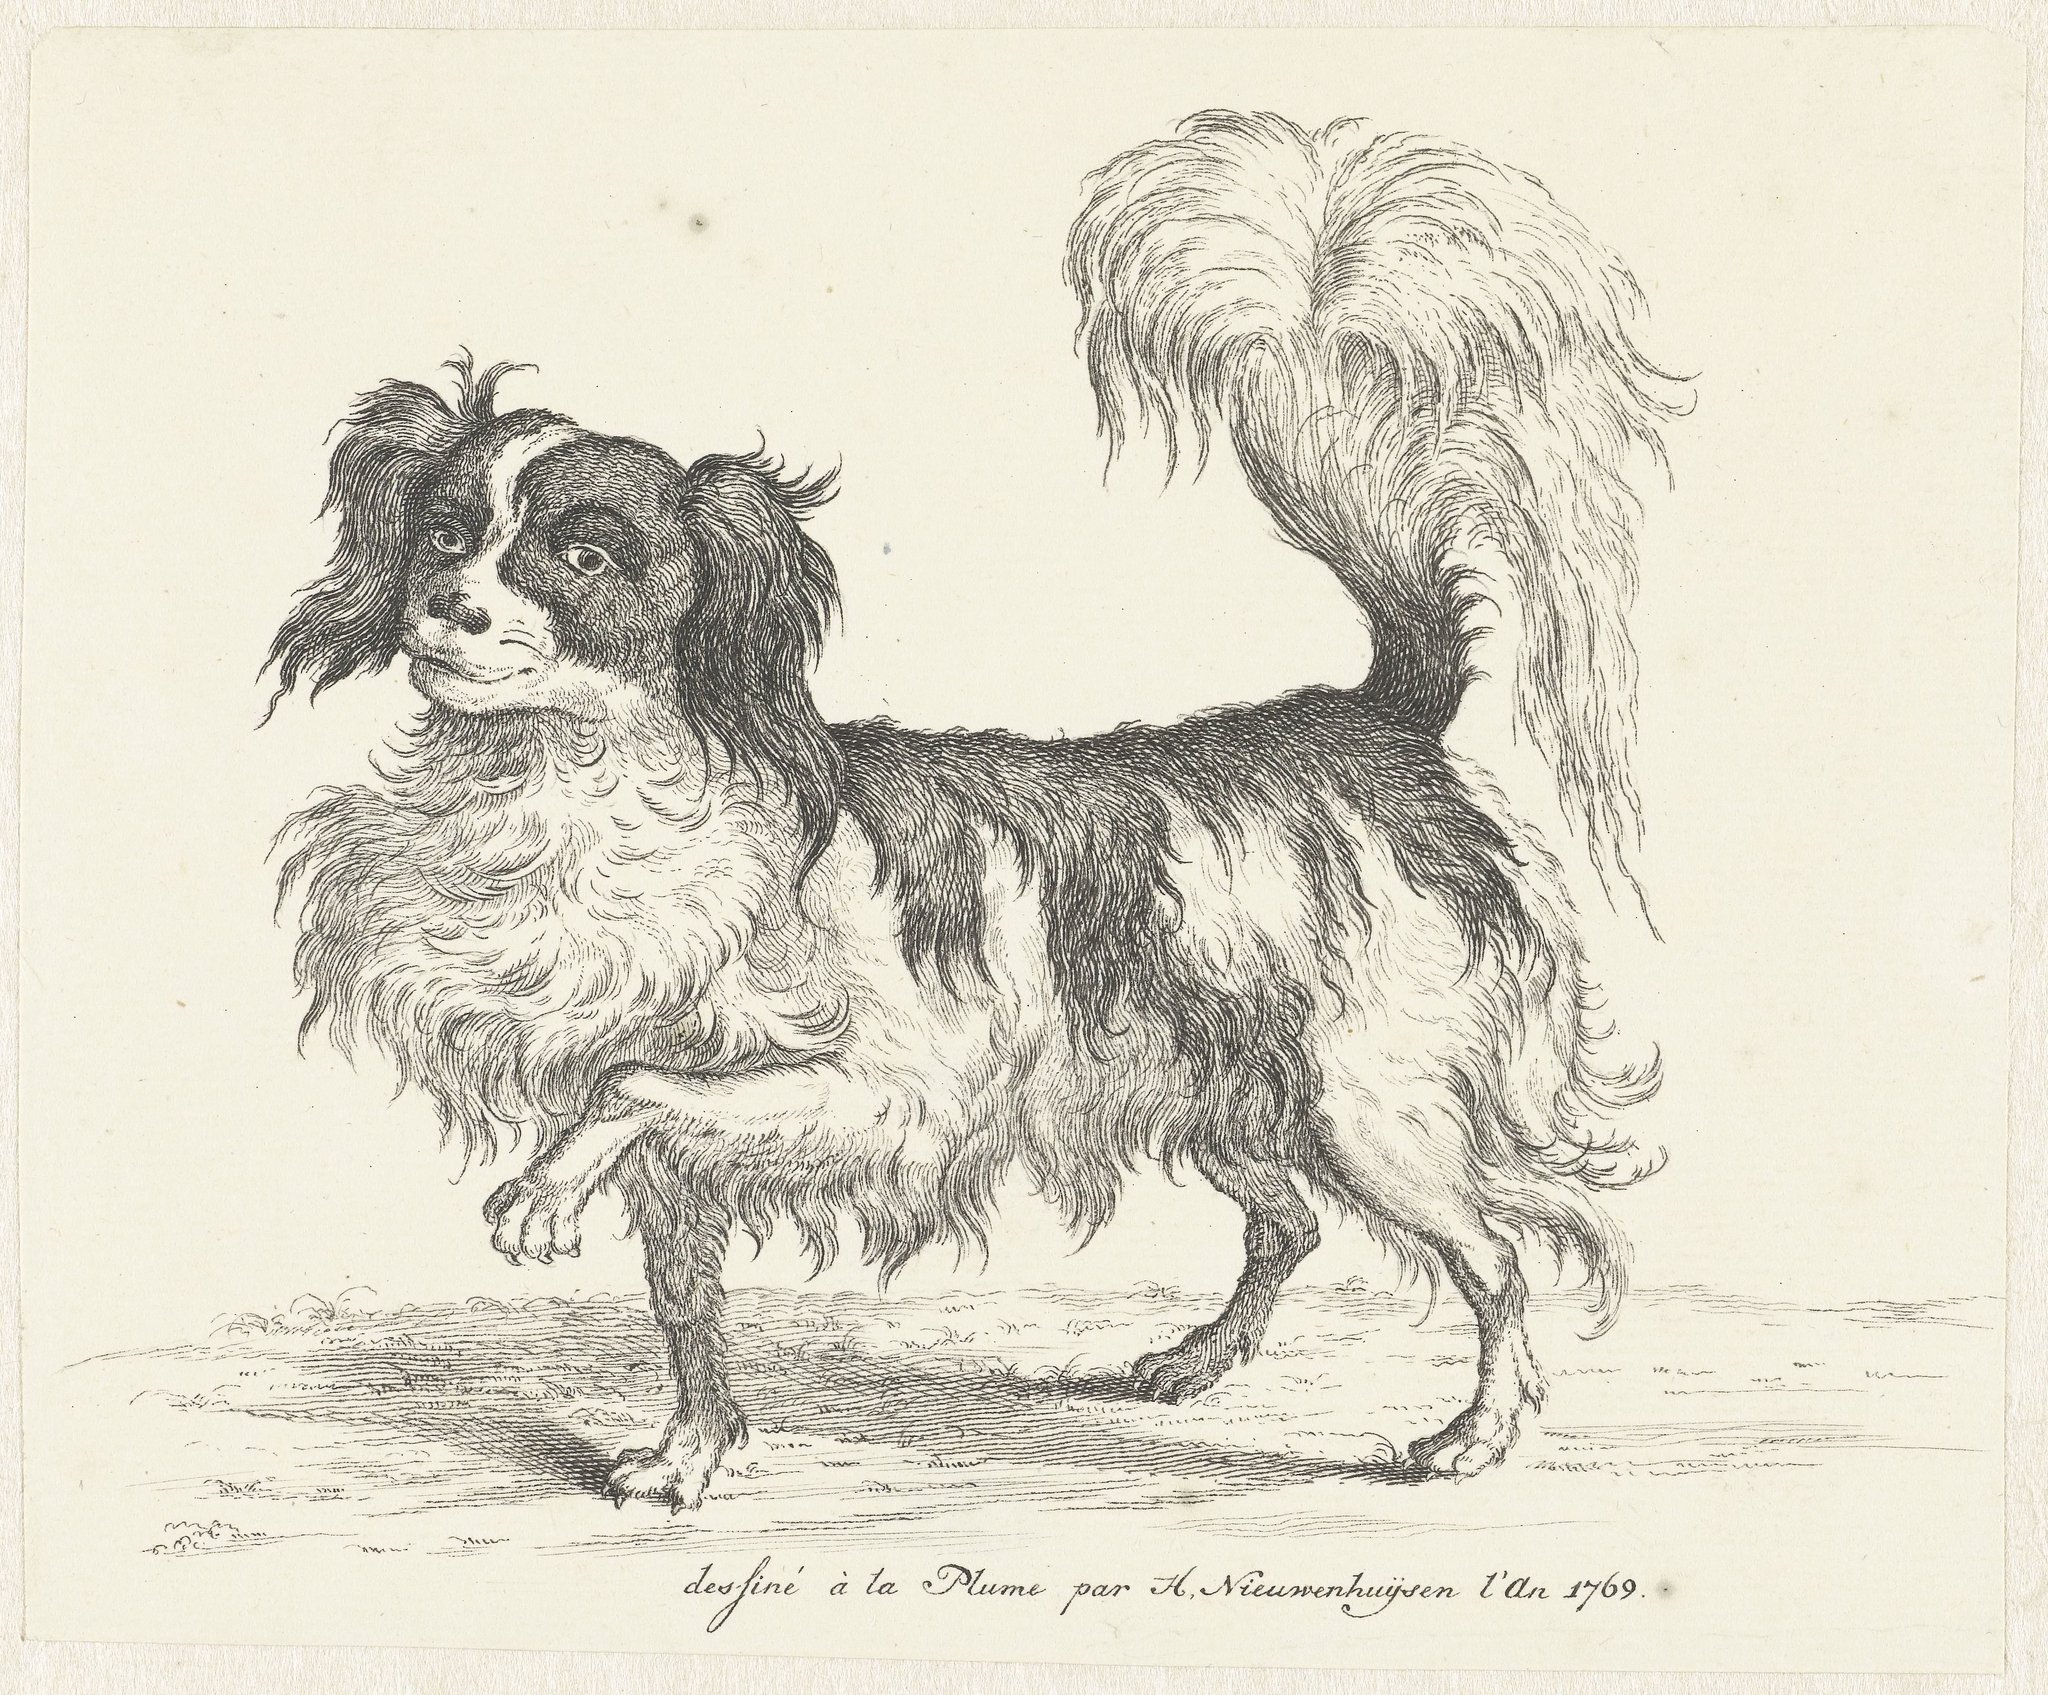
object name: drawing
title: Hond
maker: hendrik nieuwenhuysen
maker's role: draughtsman, print maker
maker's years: 1747-1794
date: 1769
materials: ink, paper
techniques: pen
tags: dog